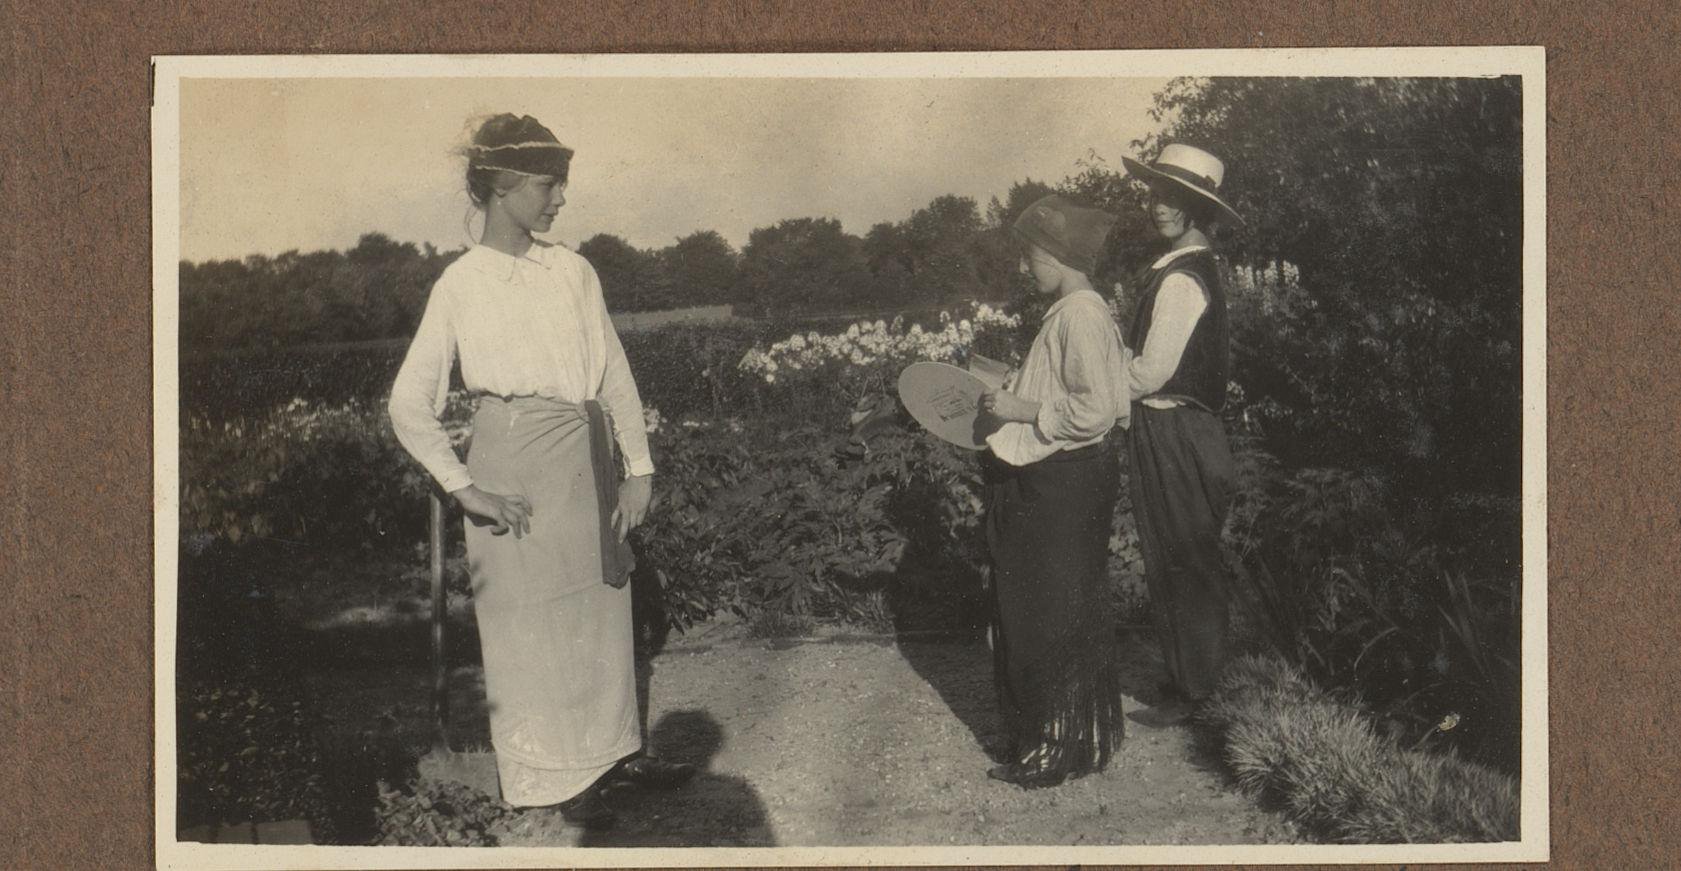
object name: photograph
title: Openluchttheater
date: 1918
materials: photographic support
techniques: photography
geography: netherlands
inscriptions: inscription: ‘Openluchttheater "De Improvisators" / "De Bijlakker." 1918.’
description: Foto op bruin albumblad 25 van familiealbum van Alphons Diepenbrock.